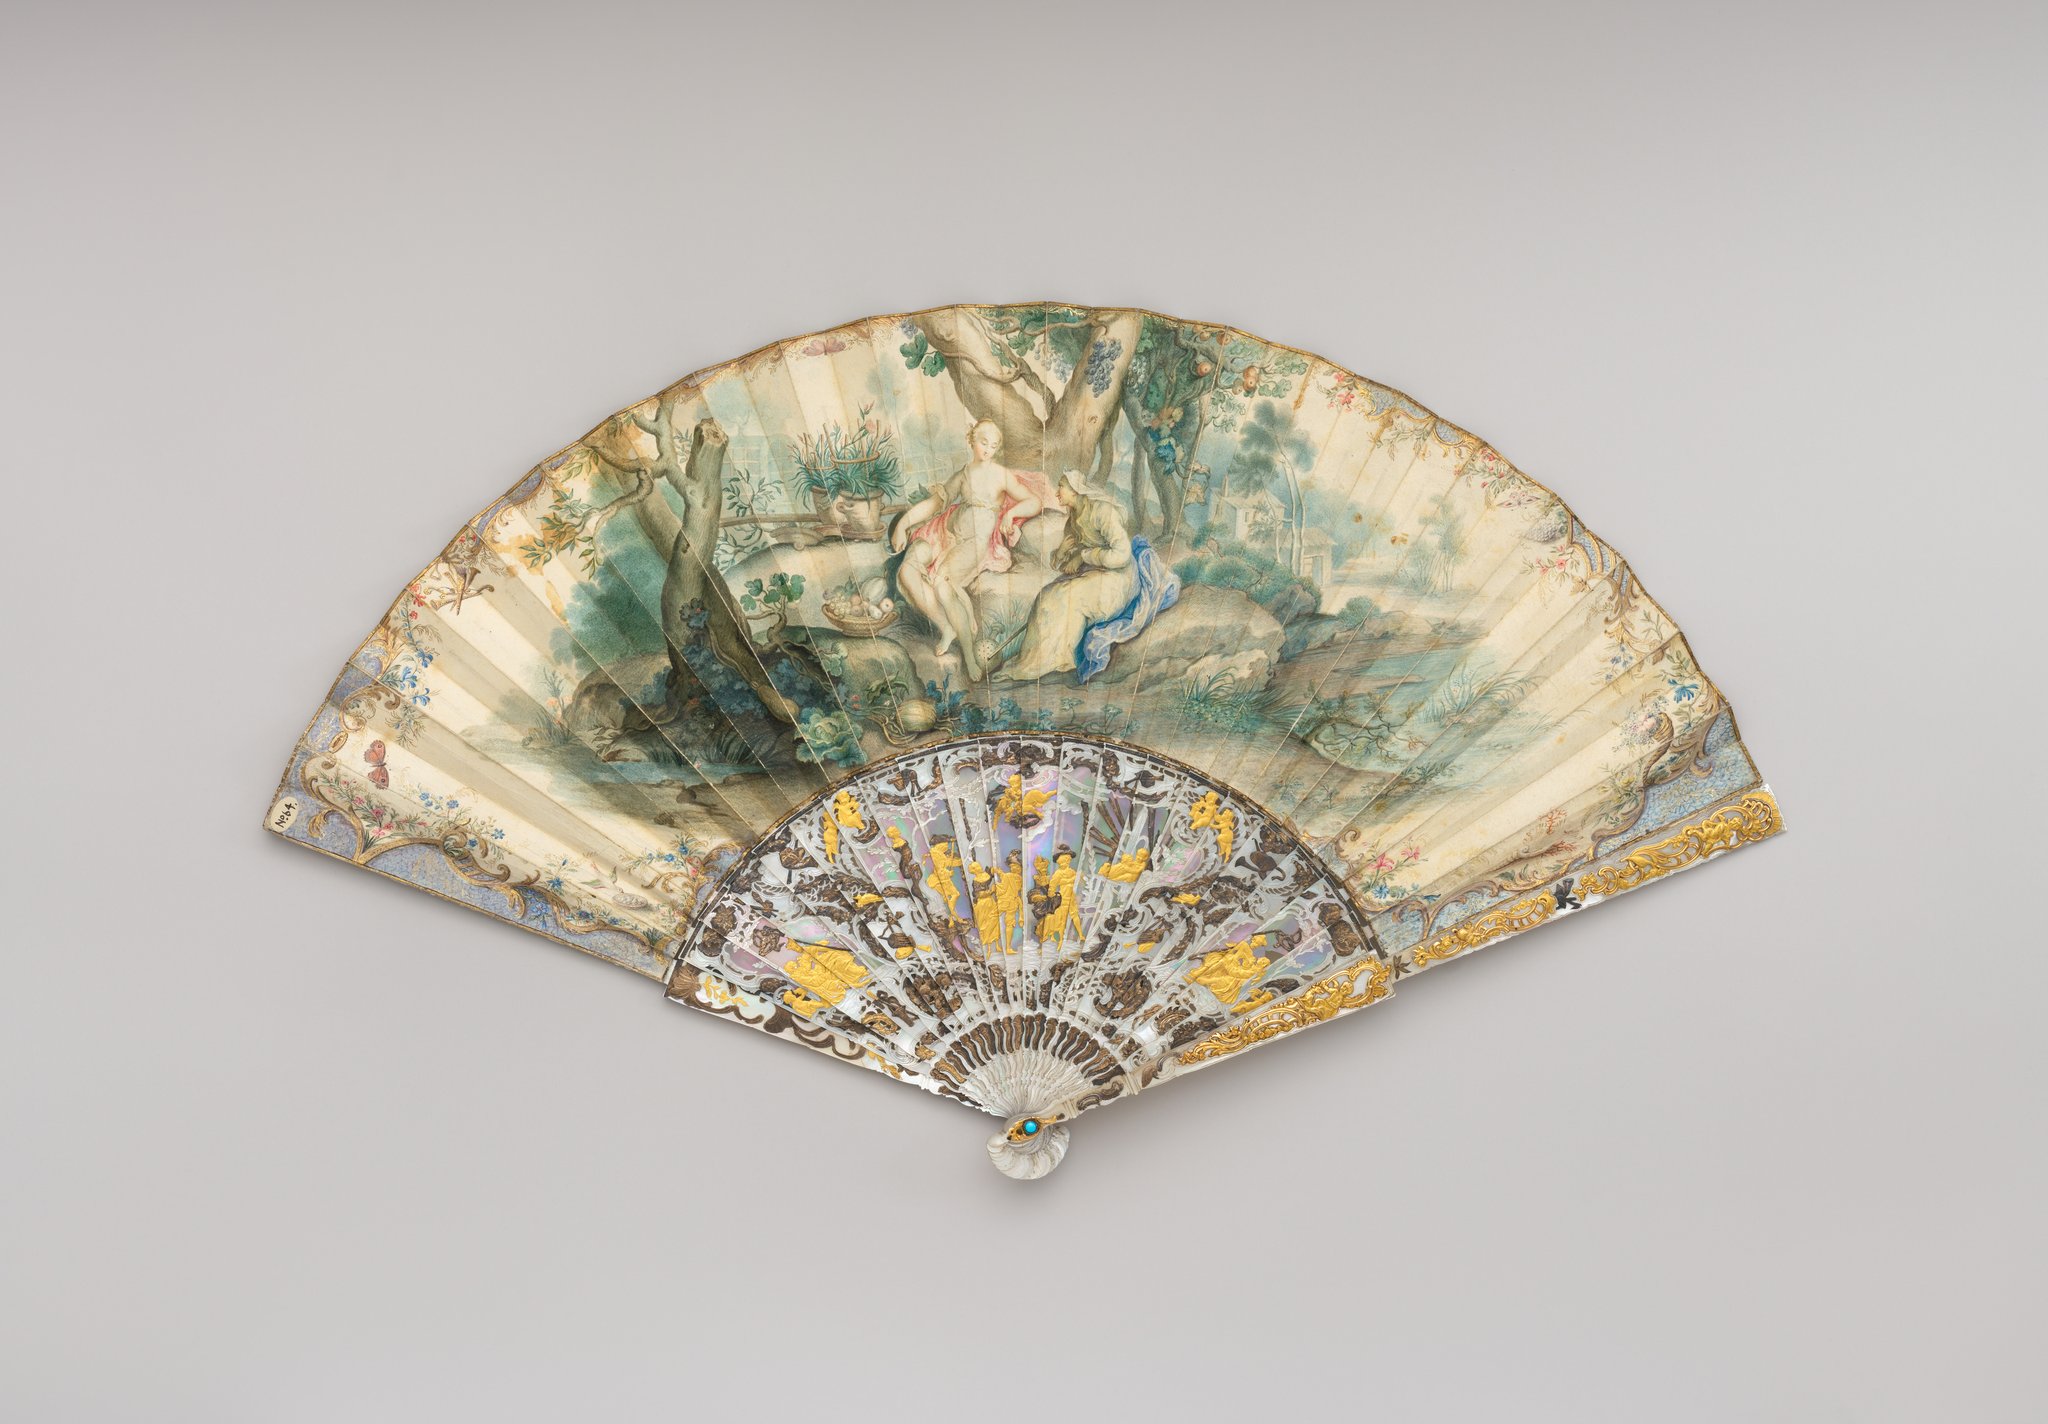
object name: fan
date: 1725-1750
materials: gilt, paint, paper, pearl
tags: women,female nudes